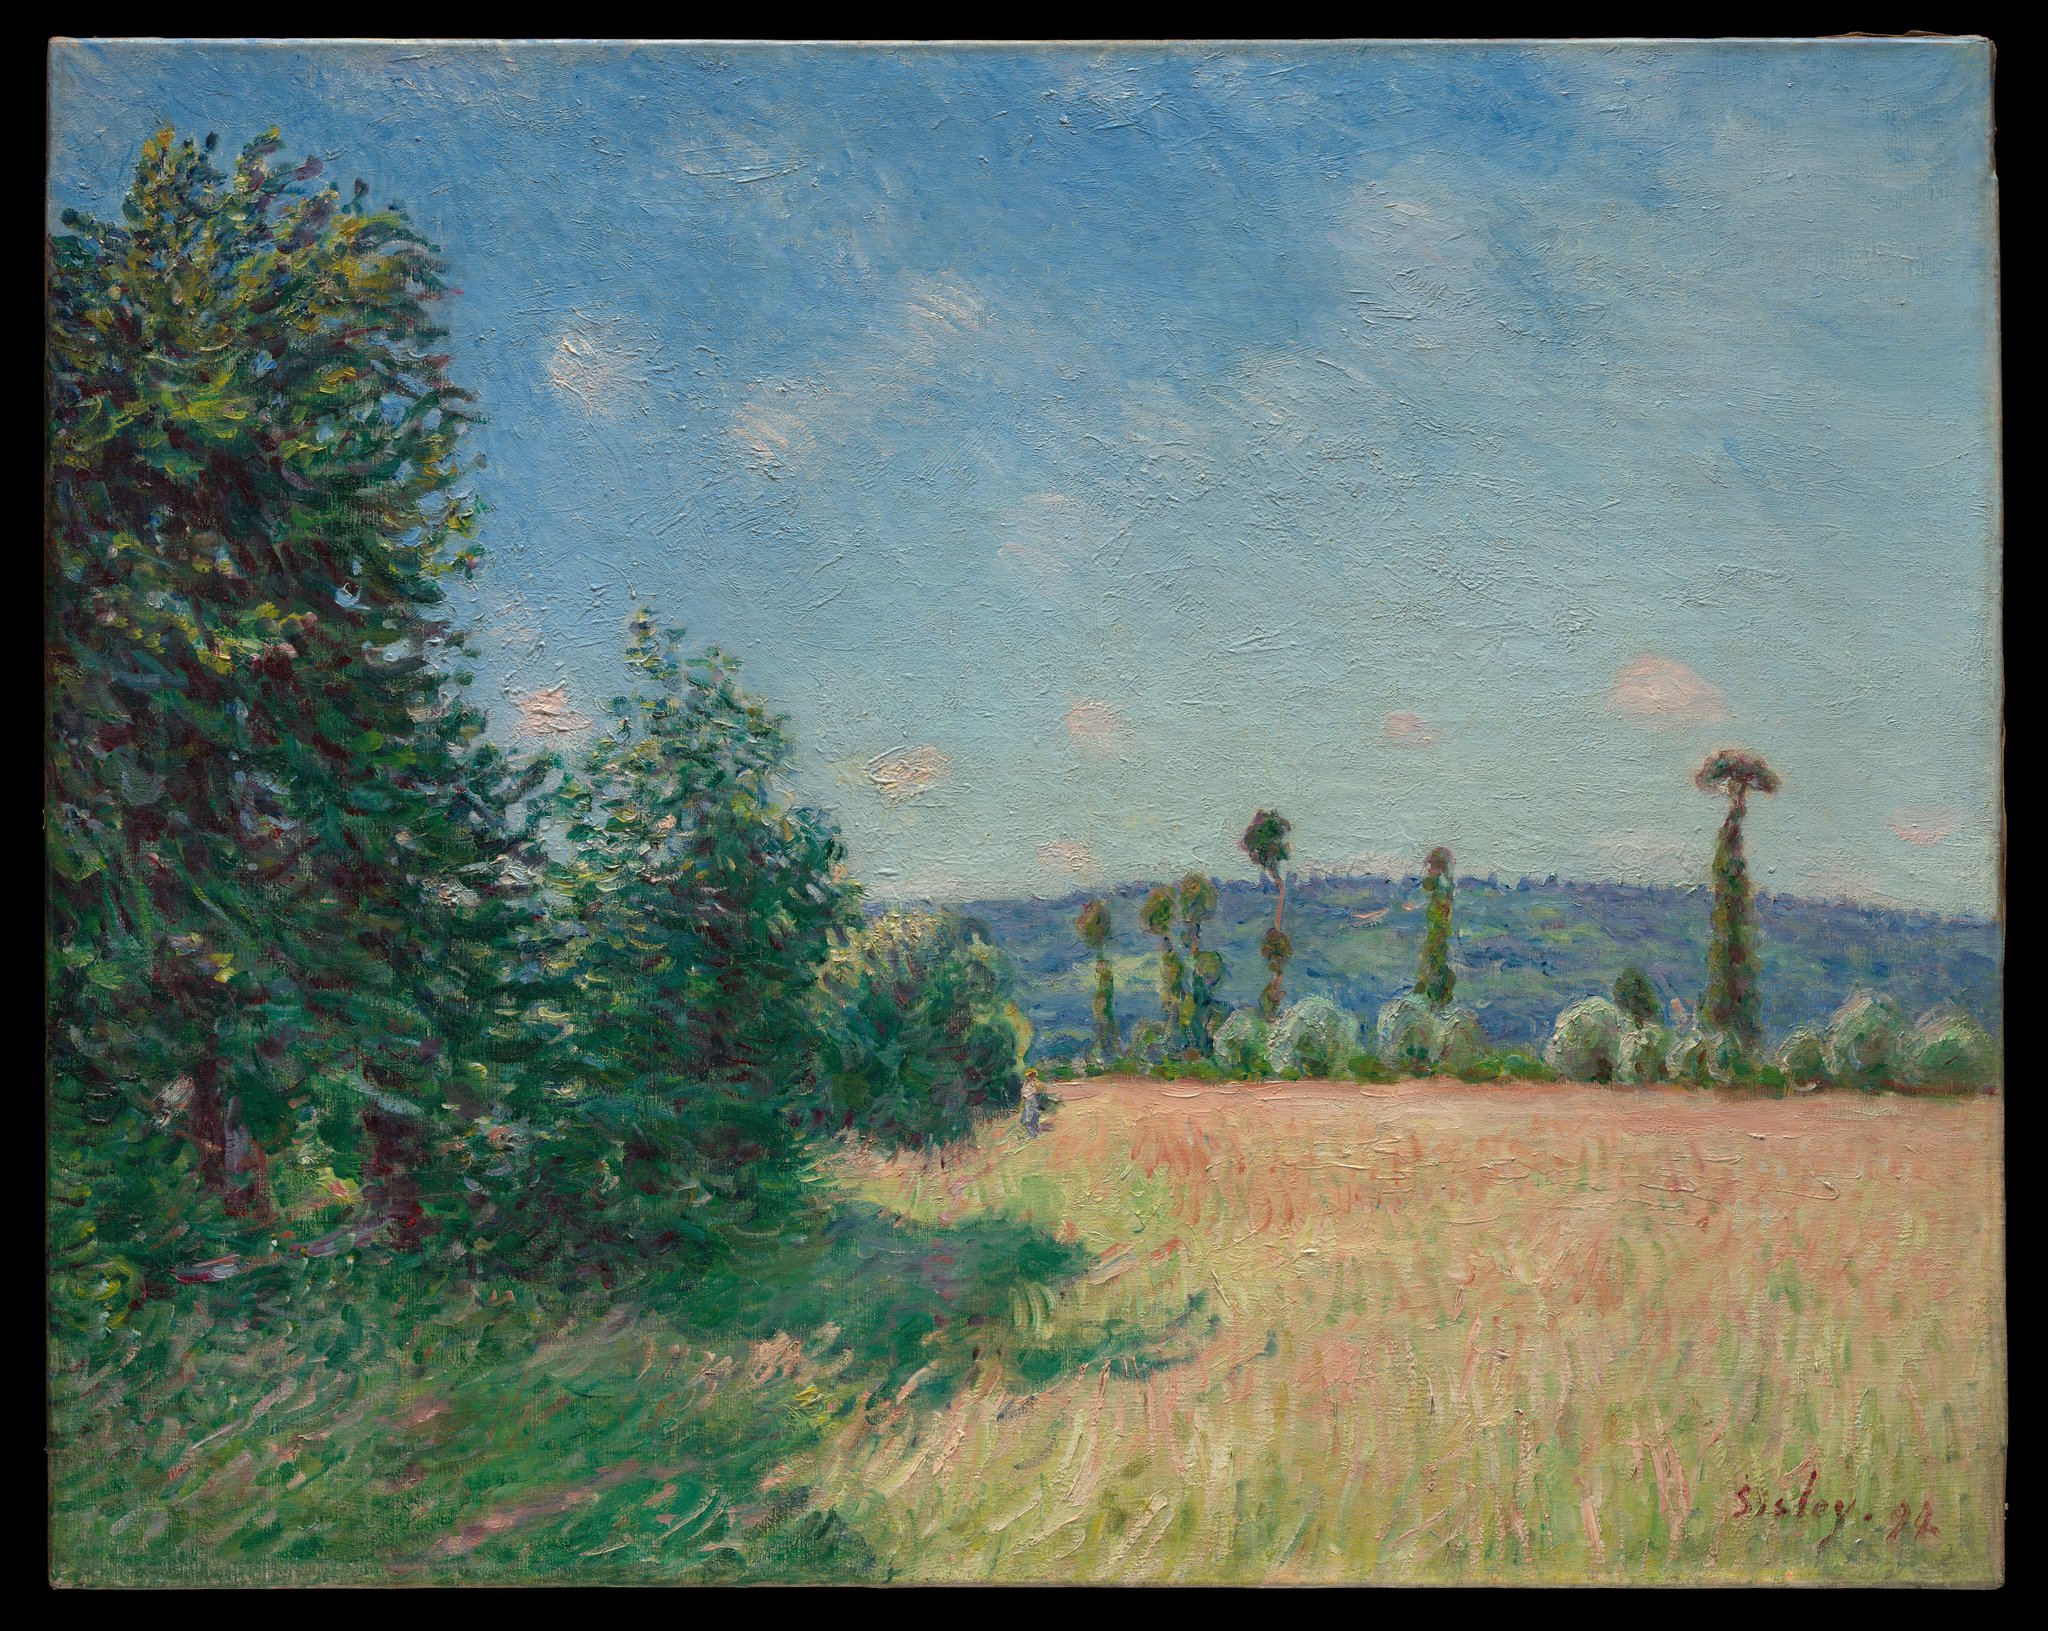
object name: painting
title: Sahurs Meadows in Morning Sun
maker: alfred sisley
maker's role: artist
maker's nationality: british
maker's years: 1839-1899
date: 1894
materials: canvas, oil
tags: landscapes